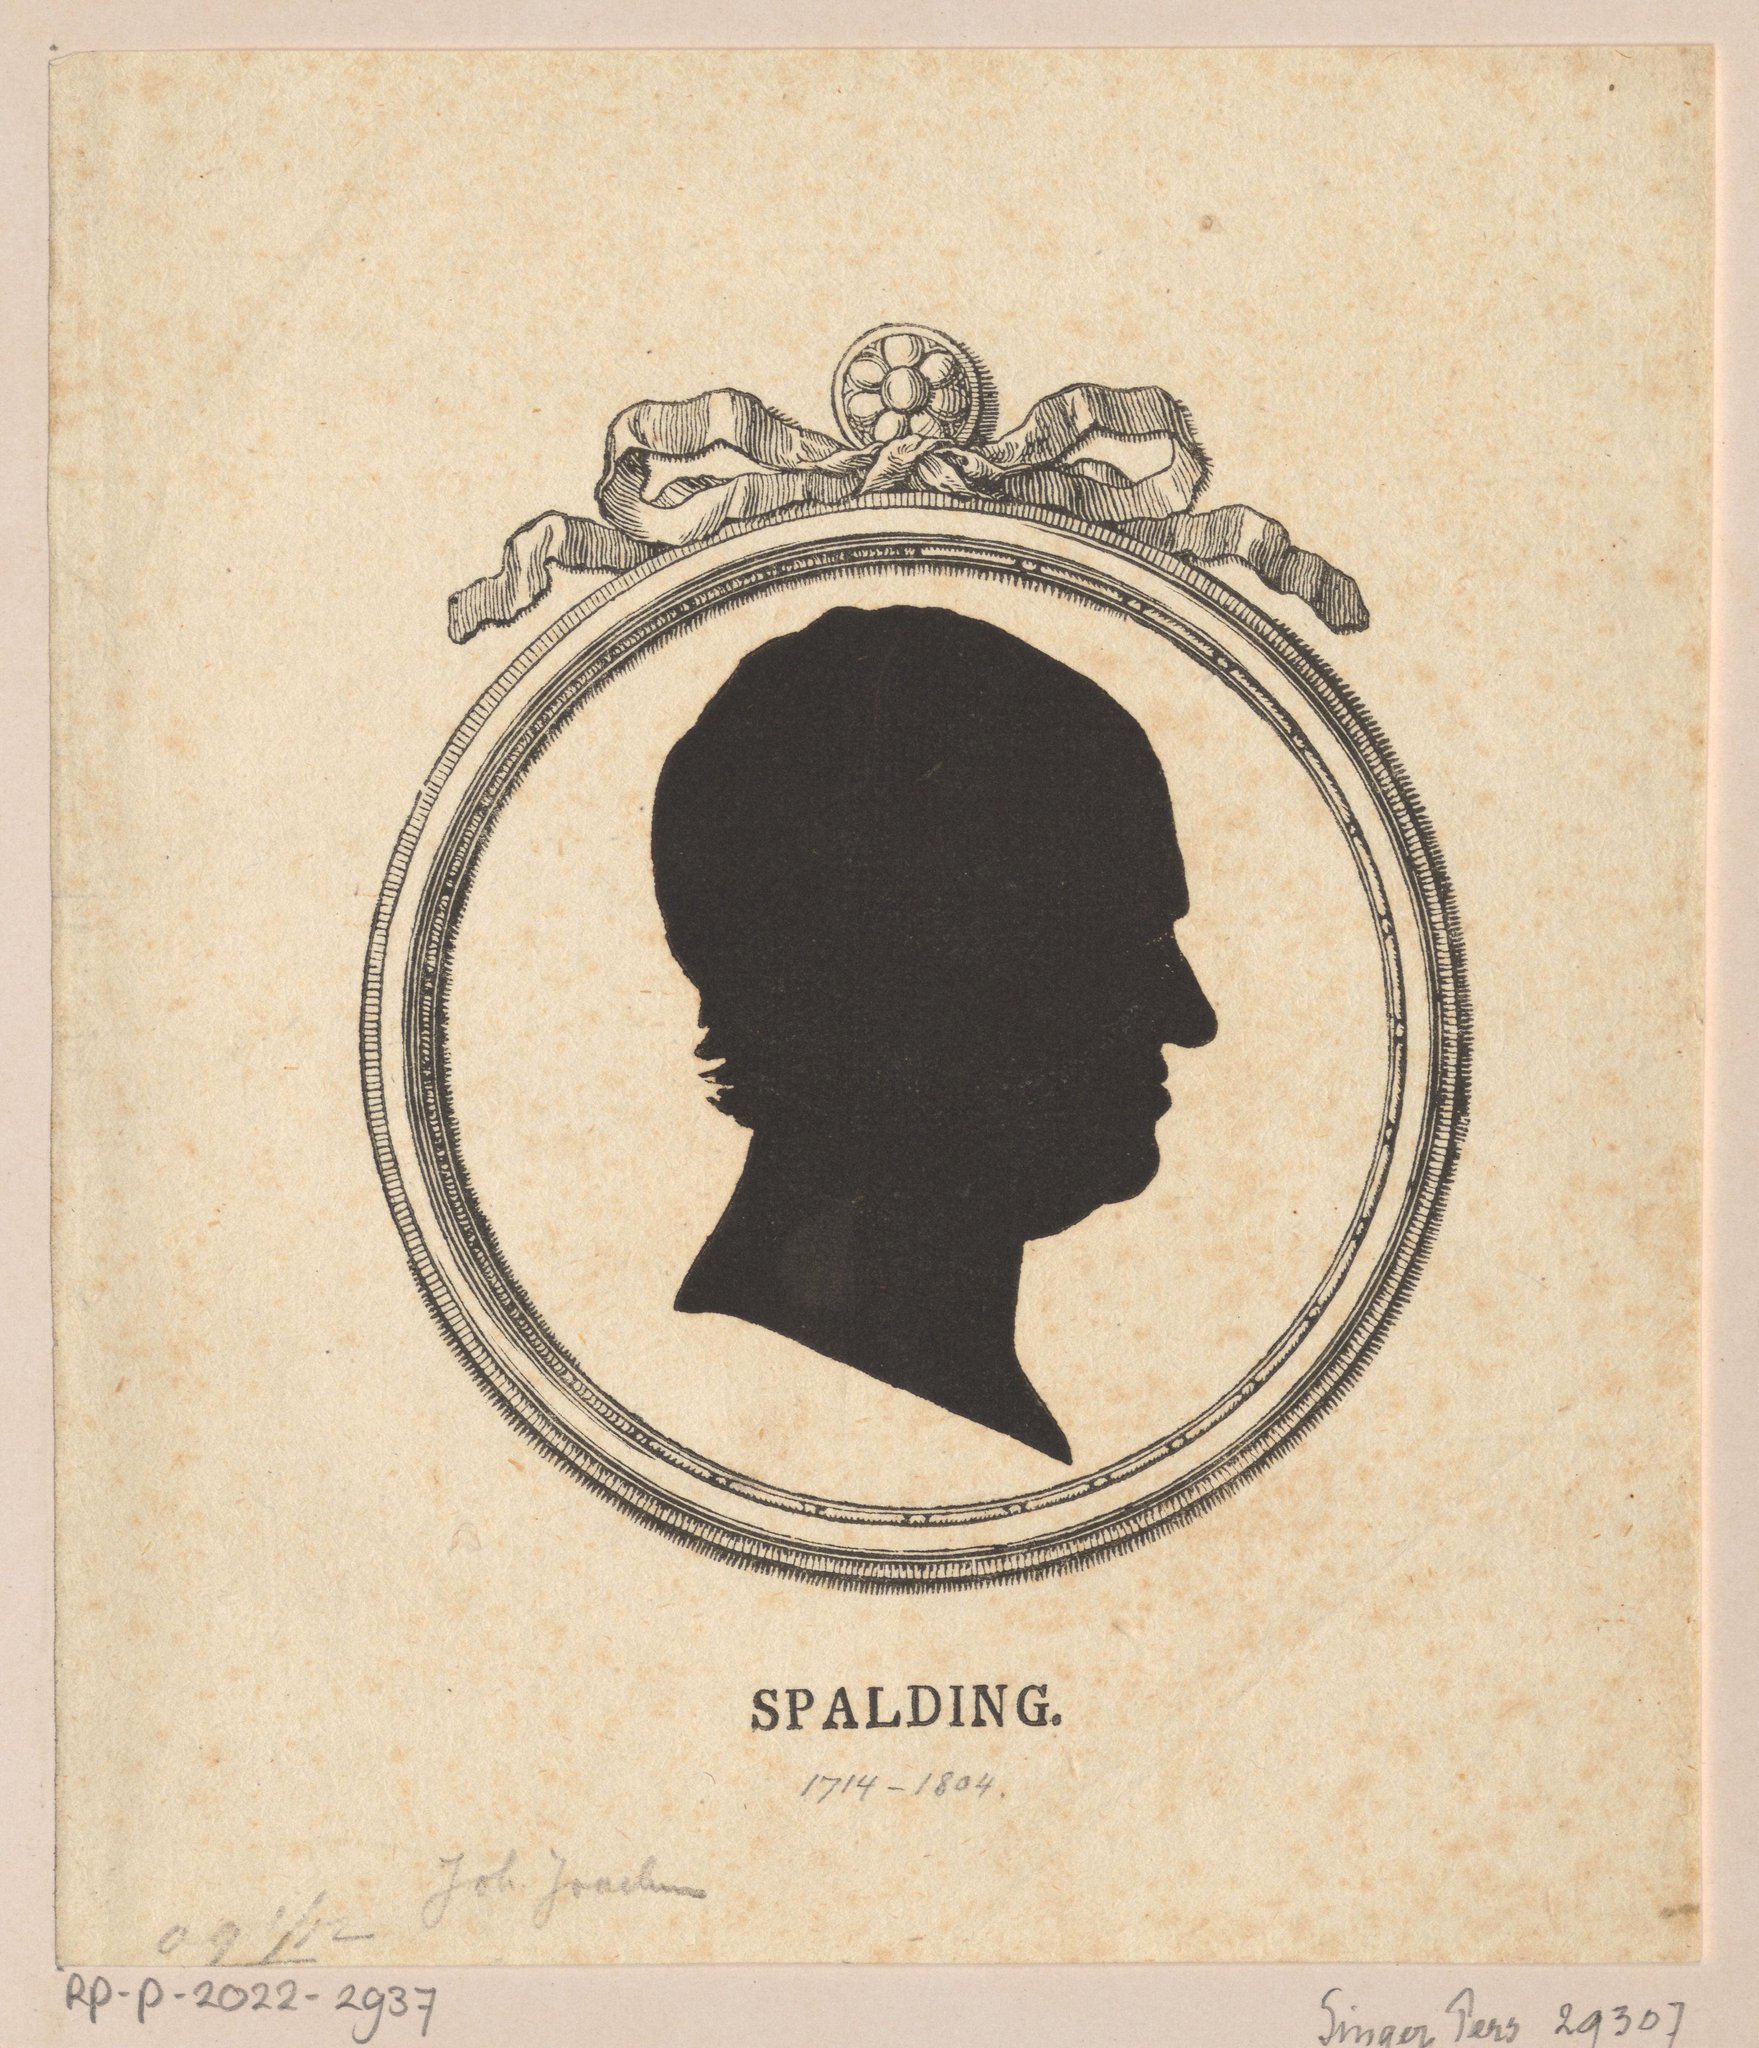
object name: print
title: Silhouetportret van Johann Joachim Spalding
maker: Anonymous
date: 1754-1850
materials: paper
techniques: letterpress printing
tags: berlin, johann joachim spalding, theologian, historical persons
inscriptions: inscription: ‘1714-1804 / Joh. Joachim / o9 [...]12’